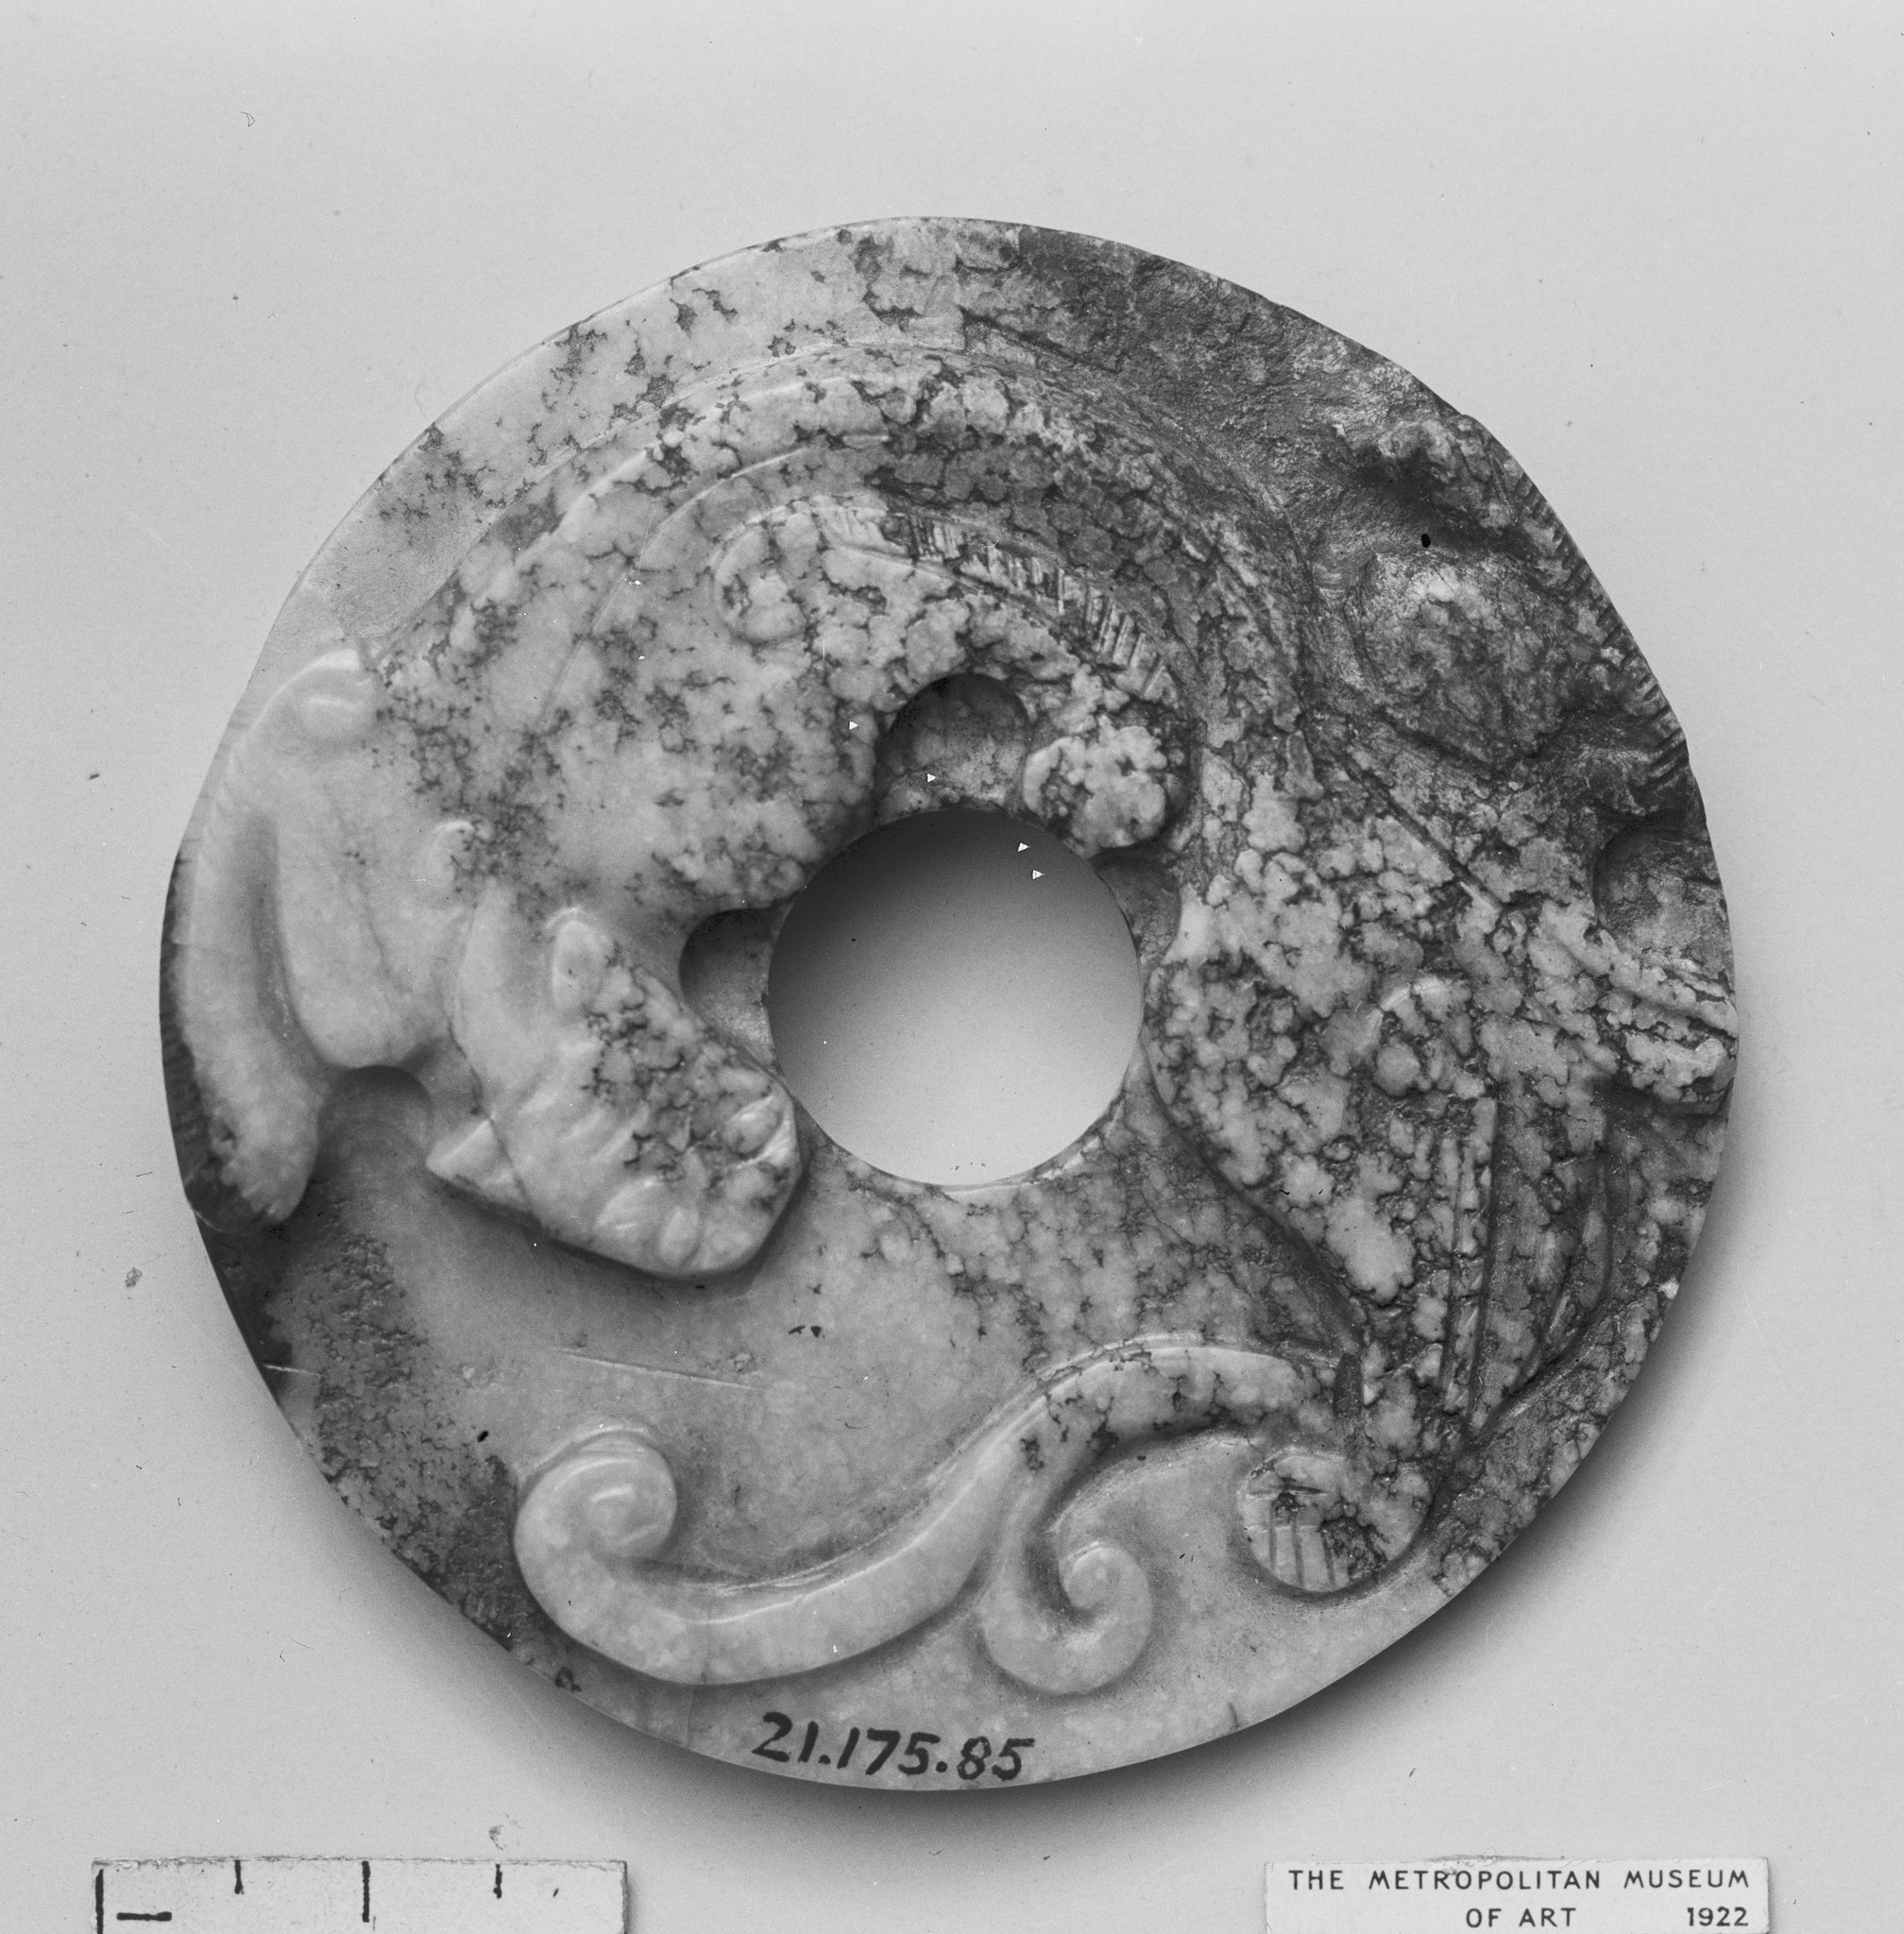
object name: disk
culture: chinese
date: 206 BCE-220 CE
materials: jade